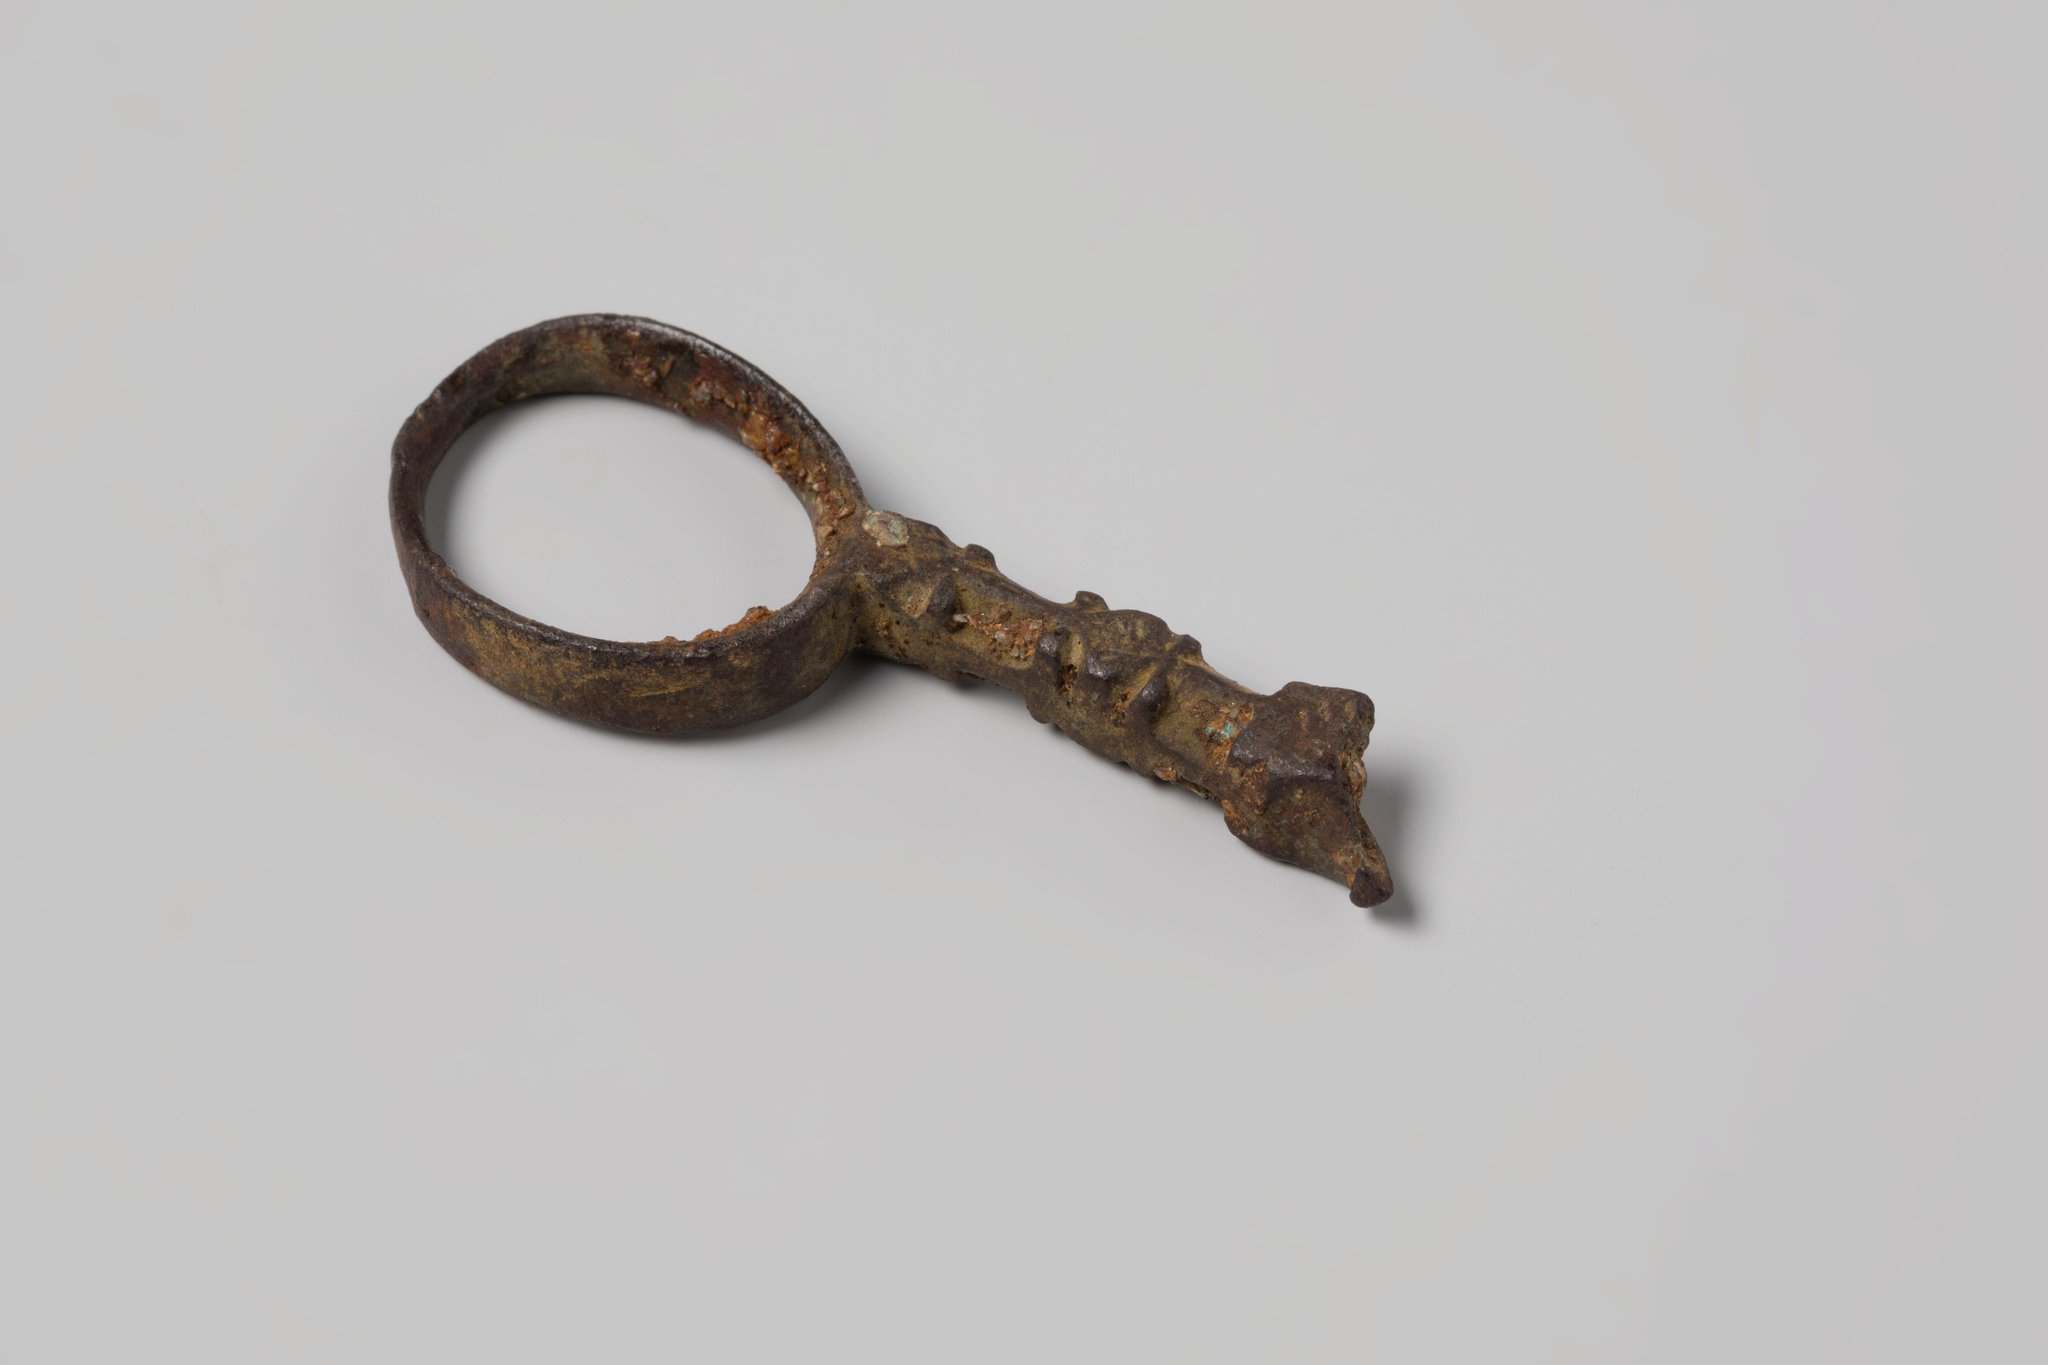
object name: pin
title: Speld uit het wrak van de Oost-Indiëvaarder Hollandia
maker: Anonymous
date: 1700-1743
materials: copper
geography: netherlands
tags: verenigde oostindische compagnie, hollandia (schip), annet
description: Tools and instruments, sewing and sailmaking, pin; fragm of shaft with bow, id. NG 1980-27H3265.